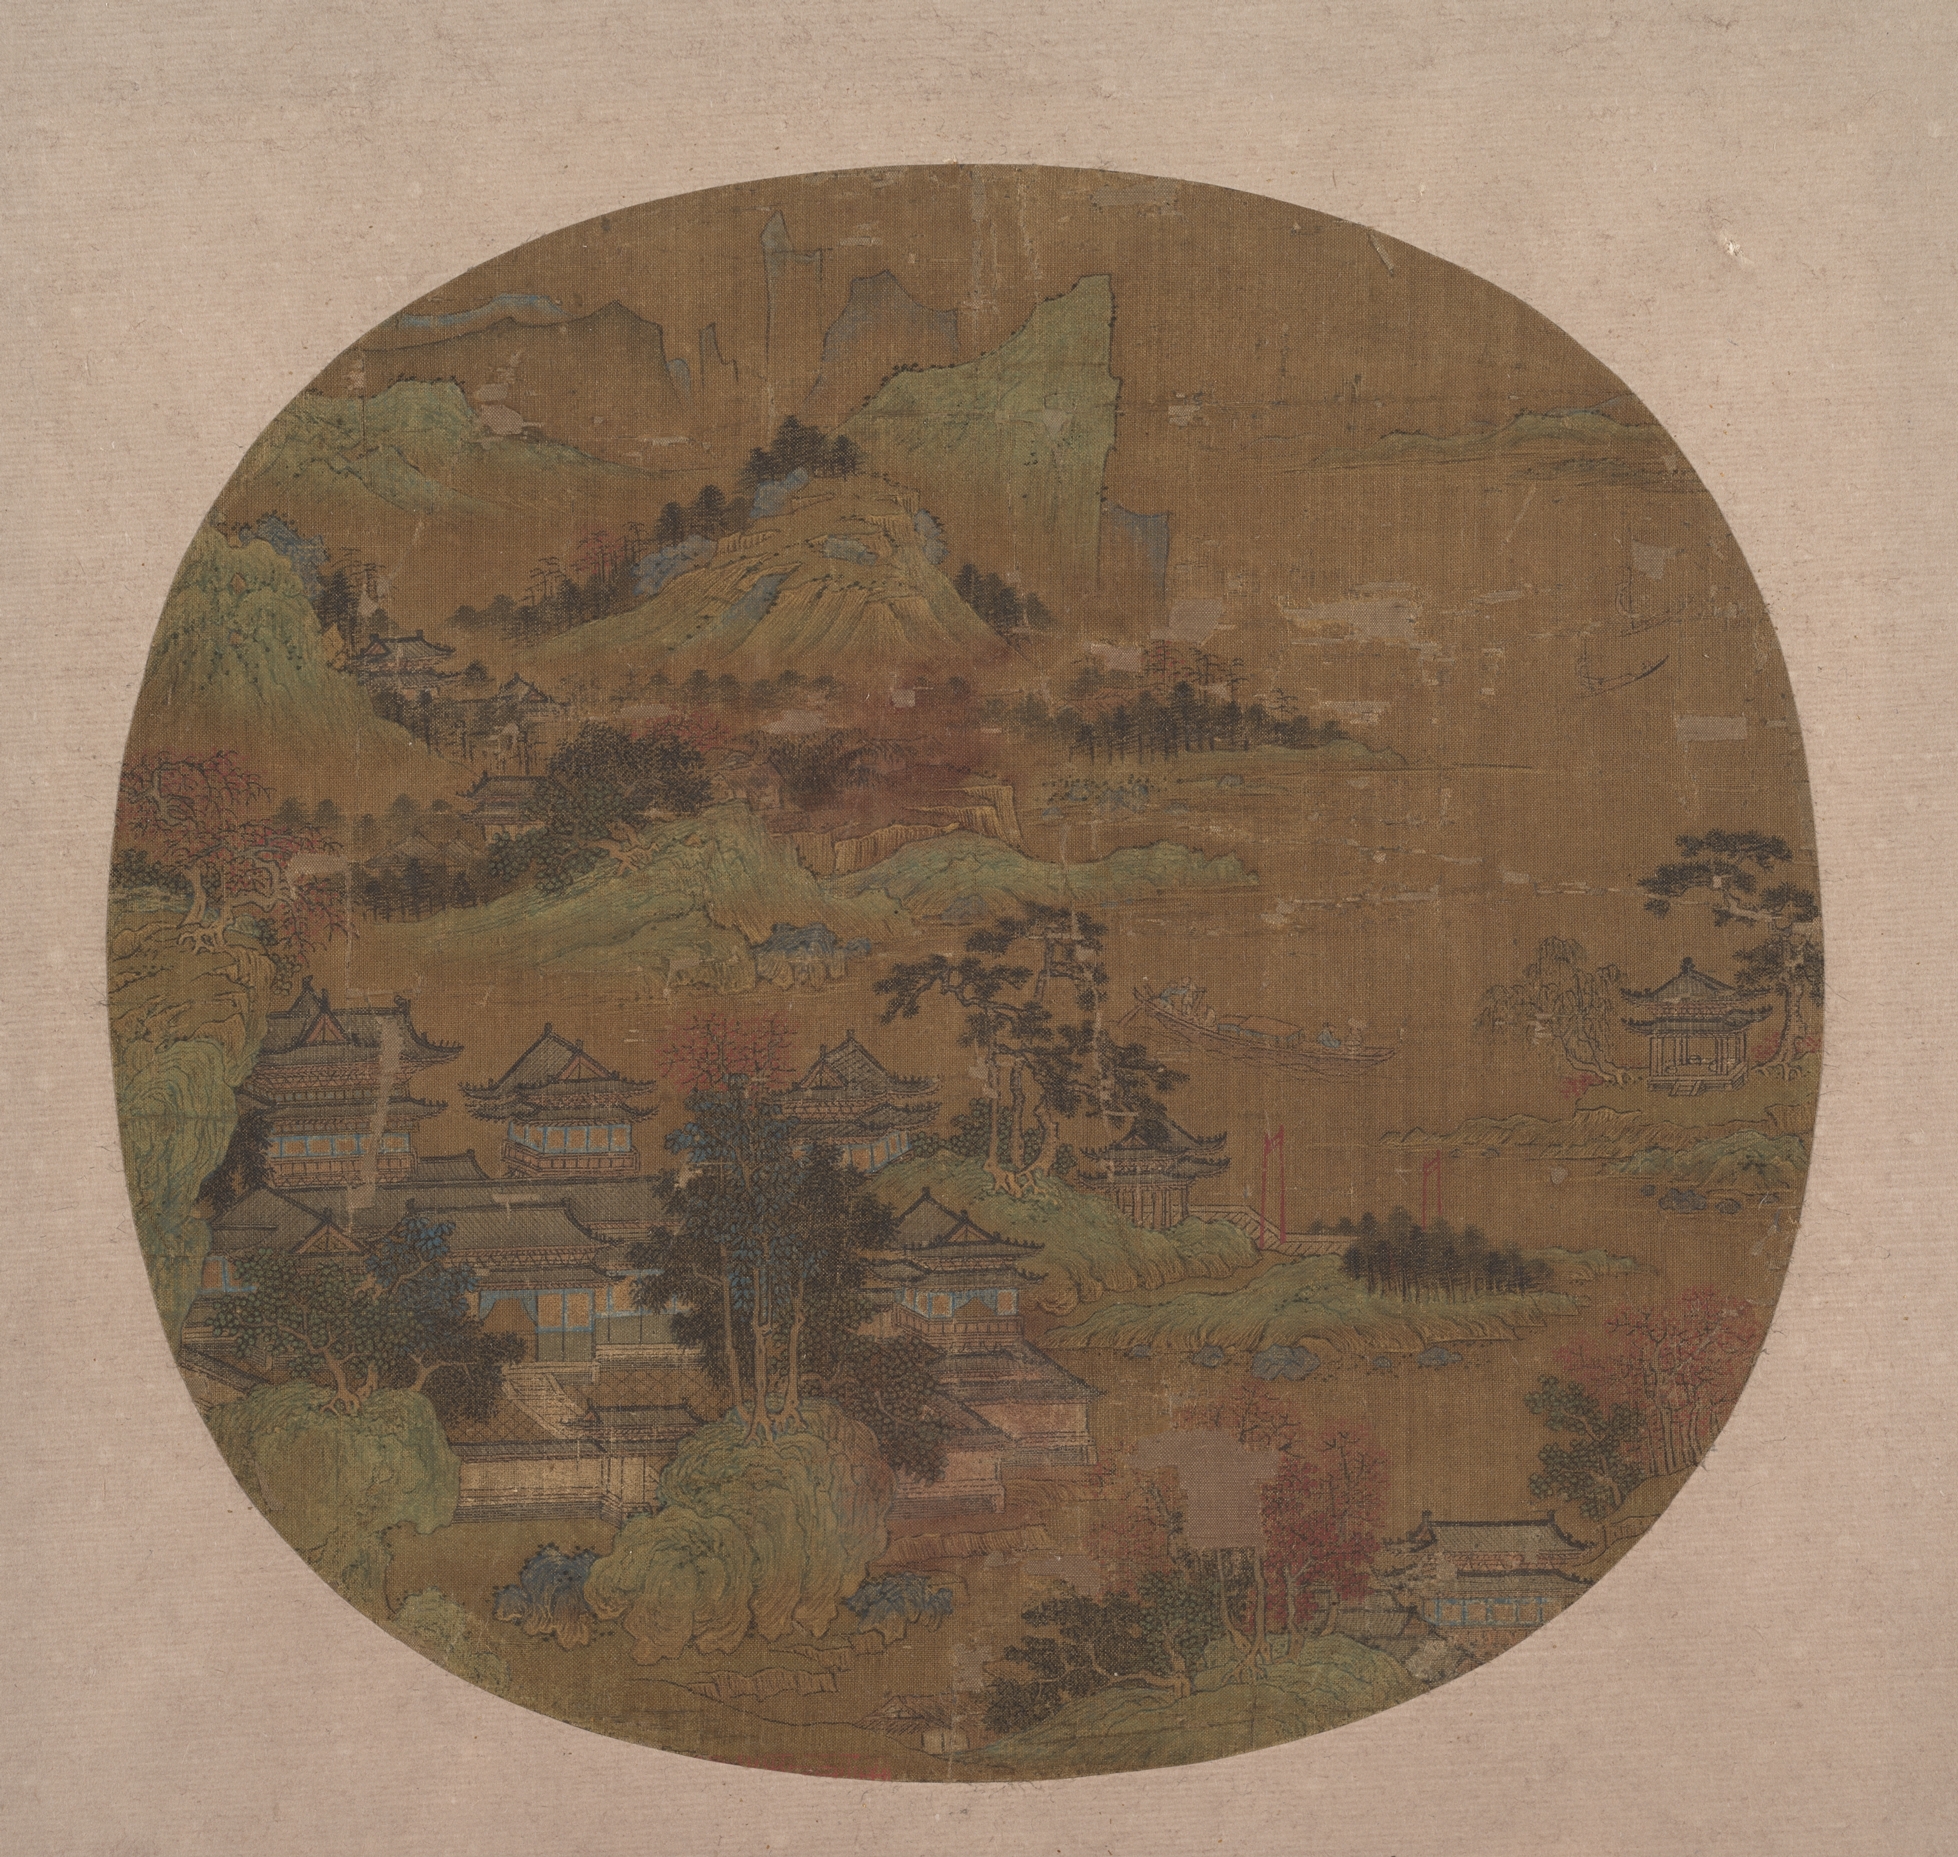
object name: fan mounted a an album leaf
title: Palaces among Autumn Mountains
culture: chinese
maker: unidentified artist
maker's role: artist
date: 1400-1433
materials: gold, ink, silk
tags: palaces,mountains,landscapes